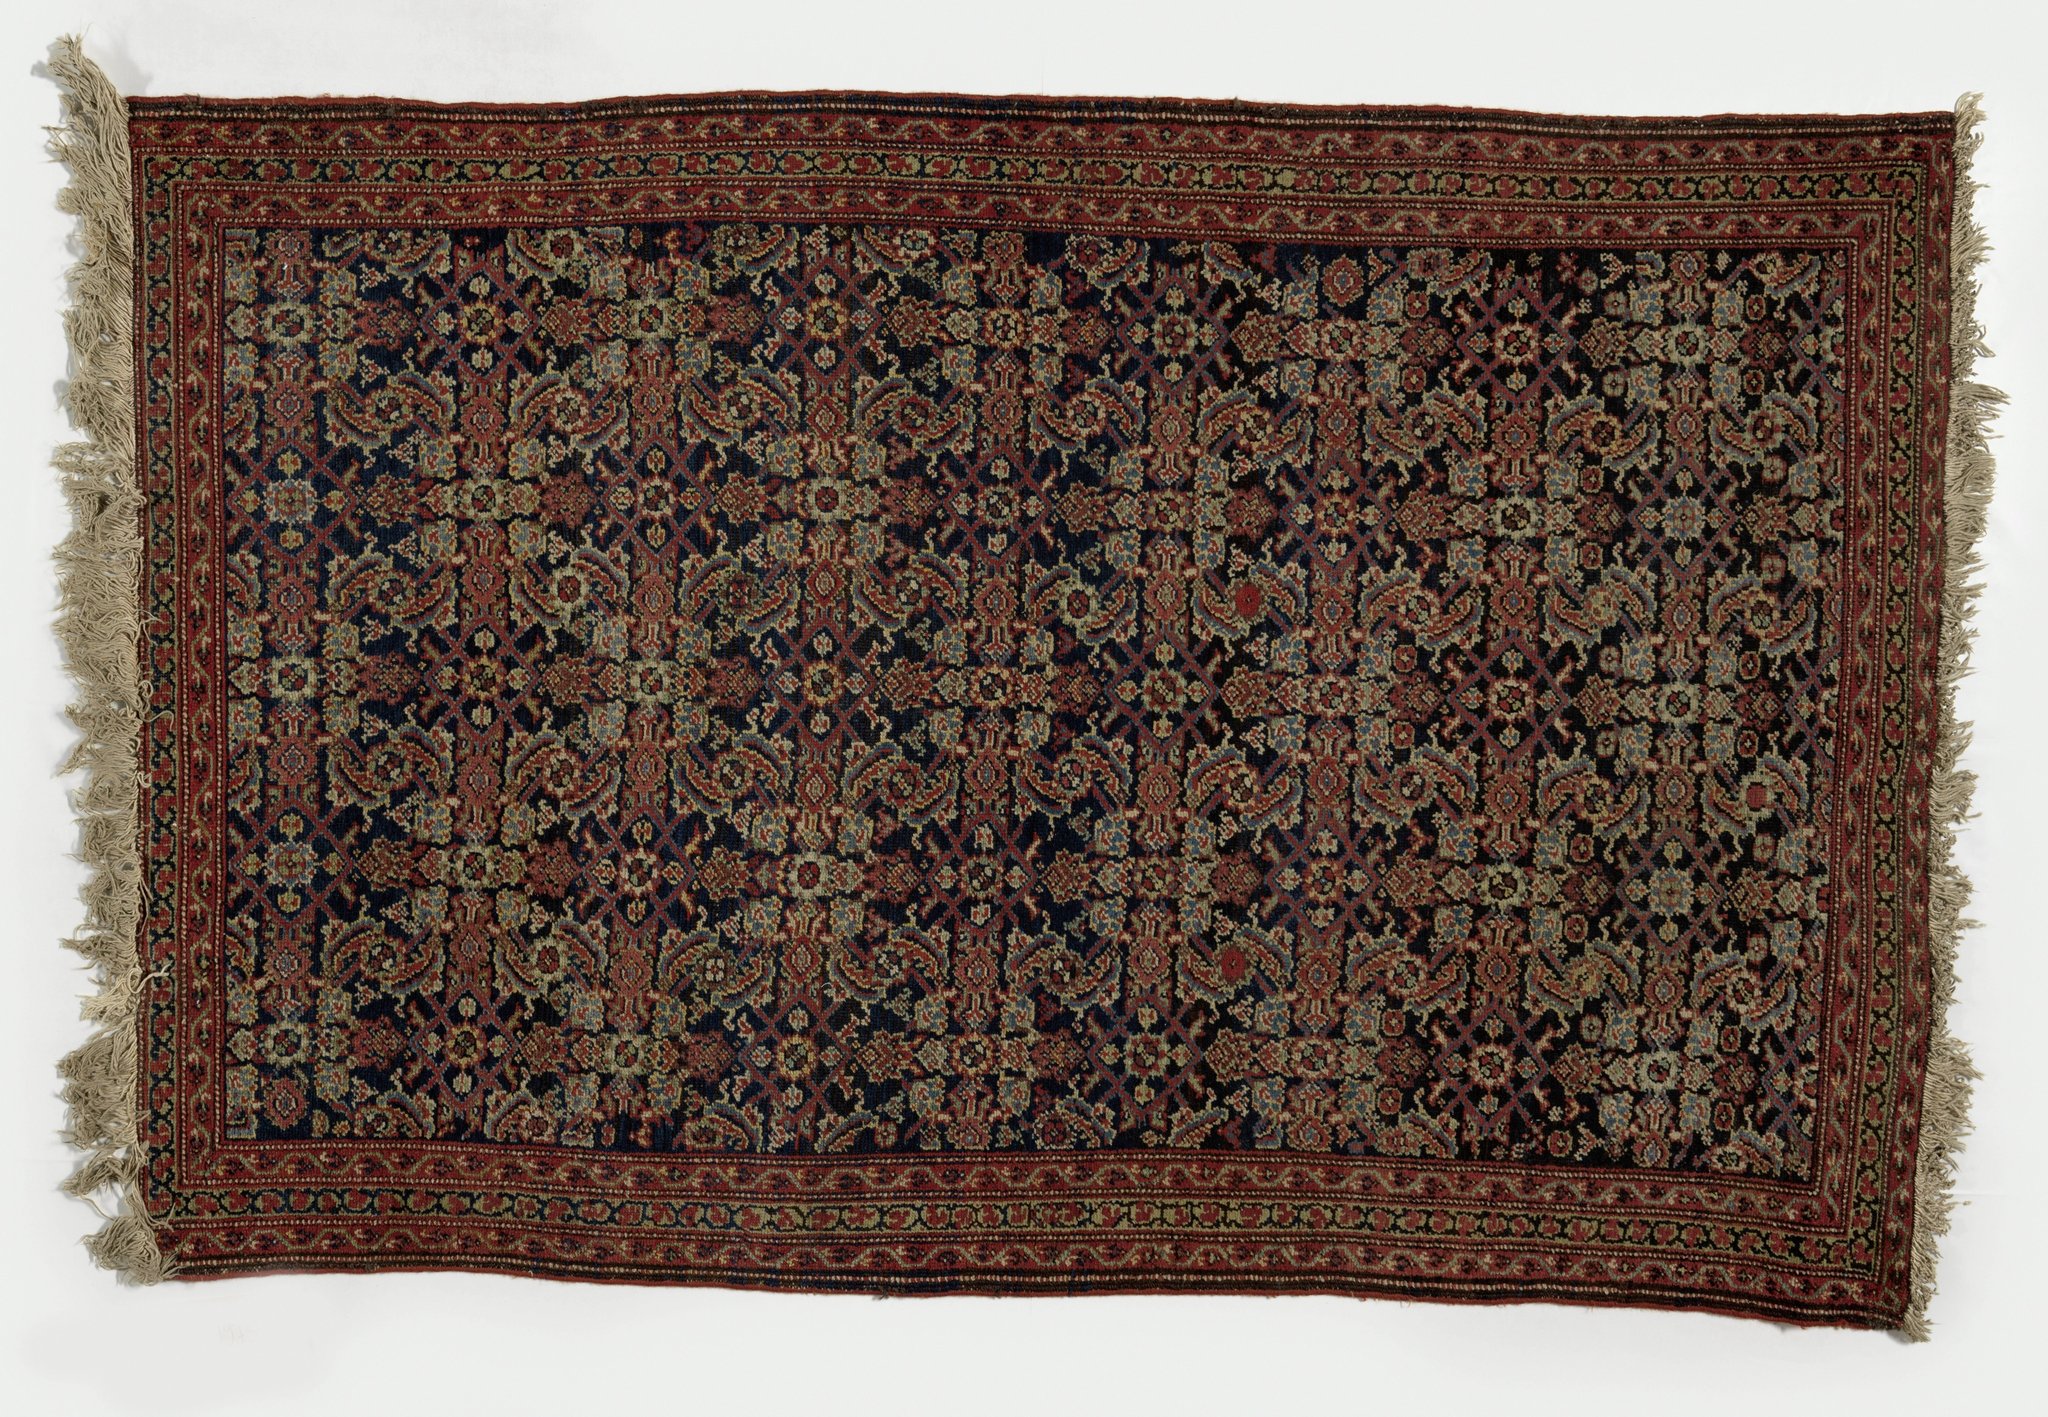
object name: oriental rug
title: Oosters tapijt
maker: Anonymous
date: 1875-1900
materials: cotton, wool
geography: central persia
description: Oosters tapijt, bloemenkleed. In het middenveld een herati-patroon tegen een donkerblauw fond. Drievoudige rand waarvan de middelste met bloemenranken.